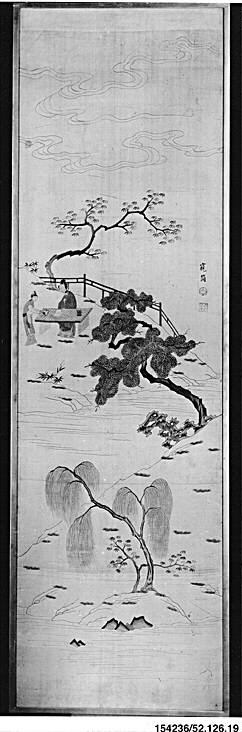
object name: screen panel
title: Screen Panel from Set of Six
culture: chinese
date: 1767-1833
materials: silk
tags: human figures